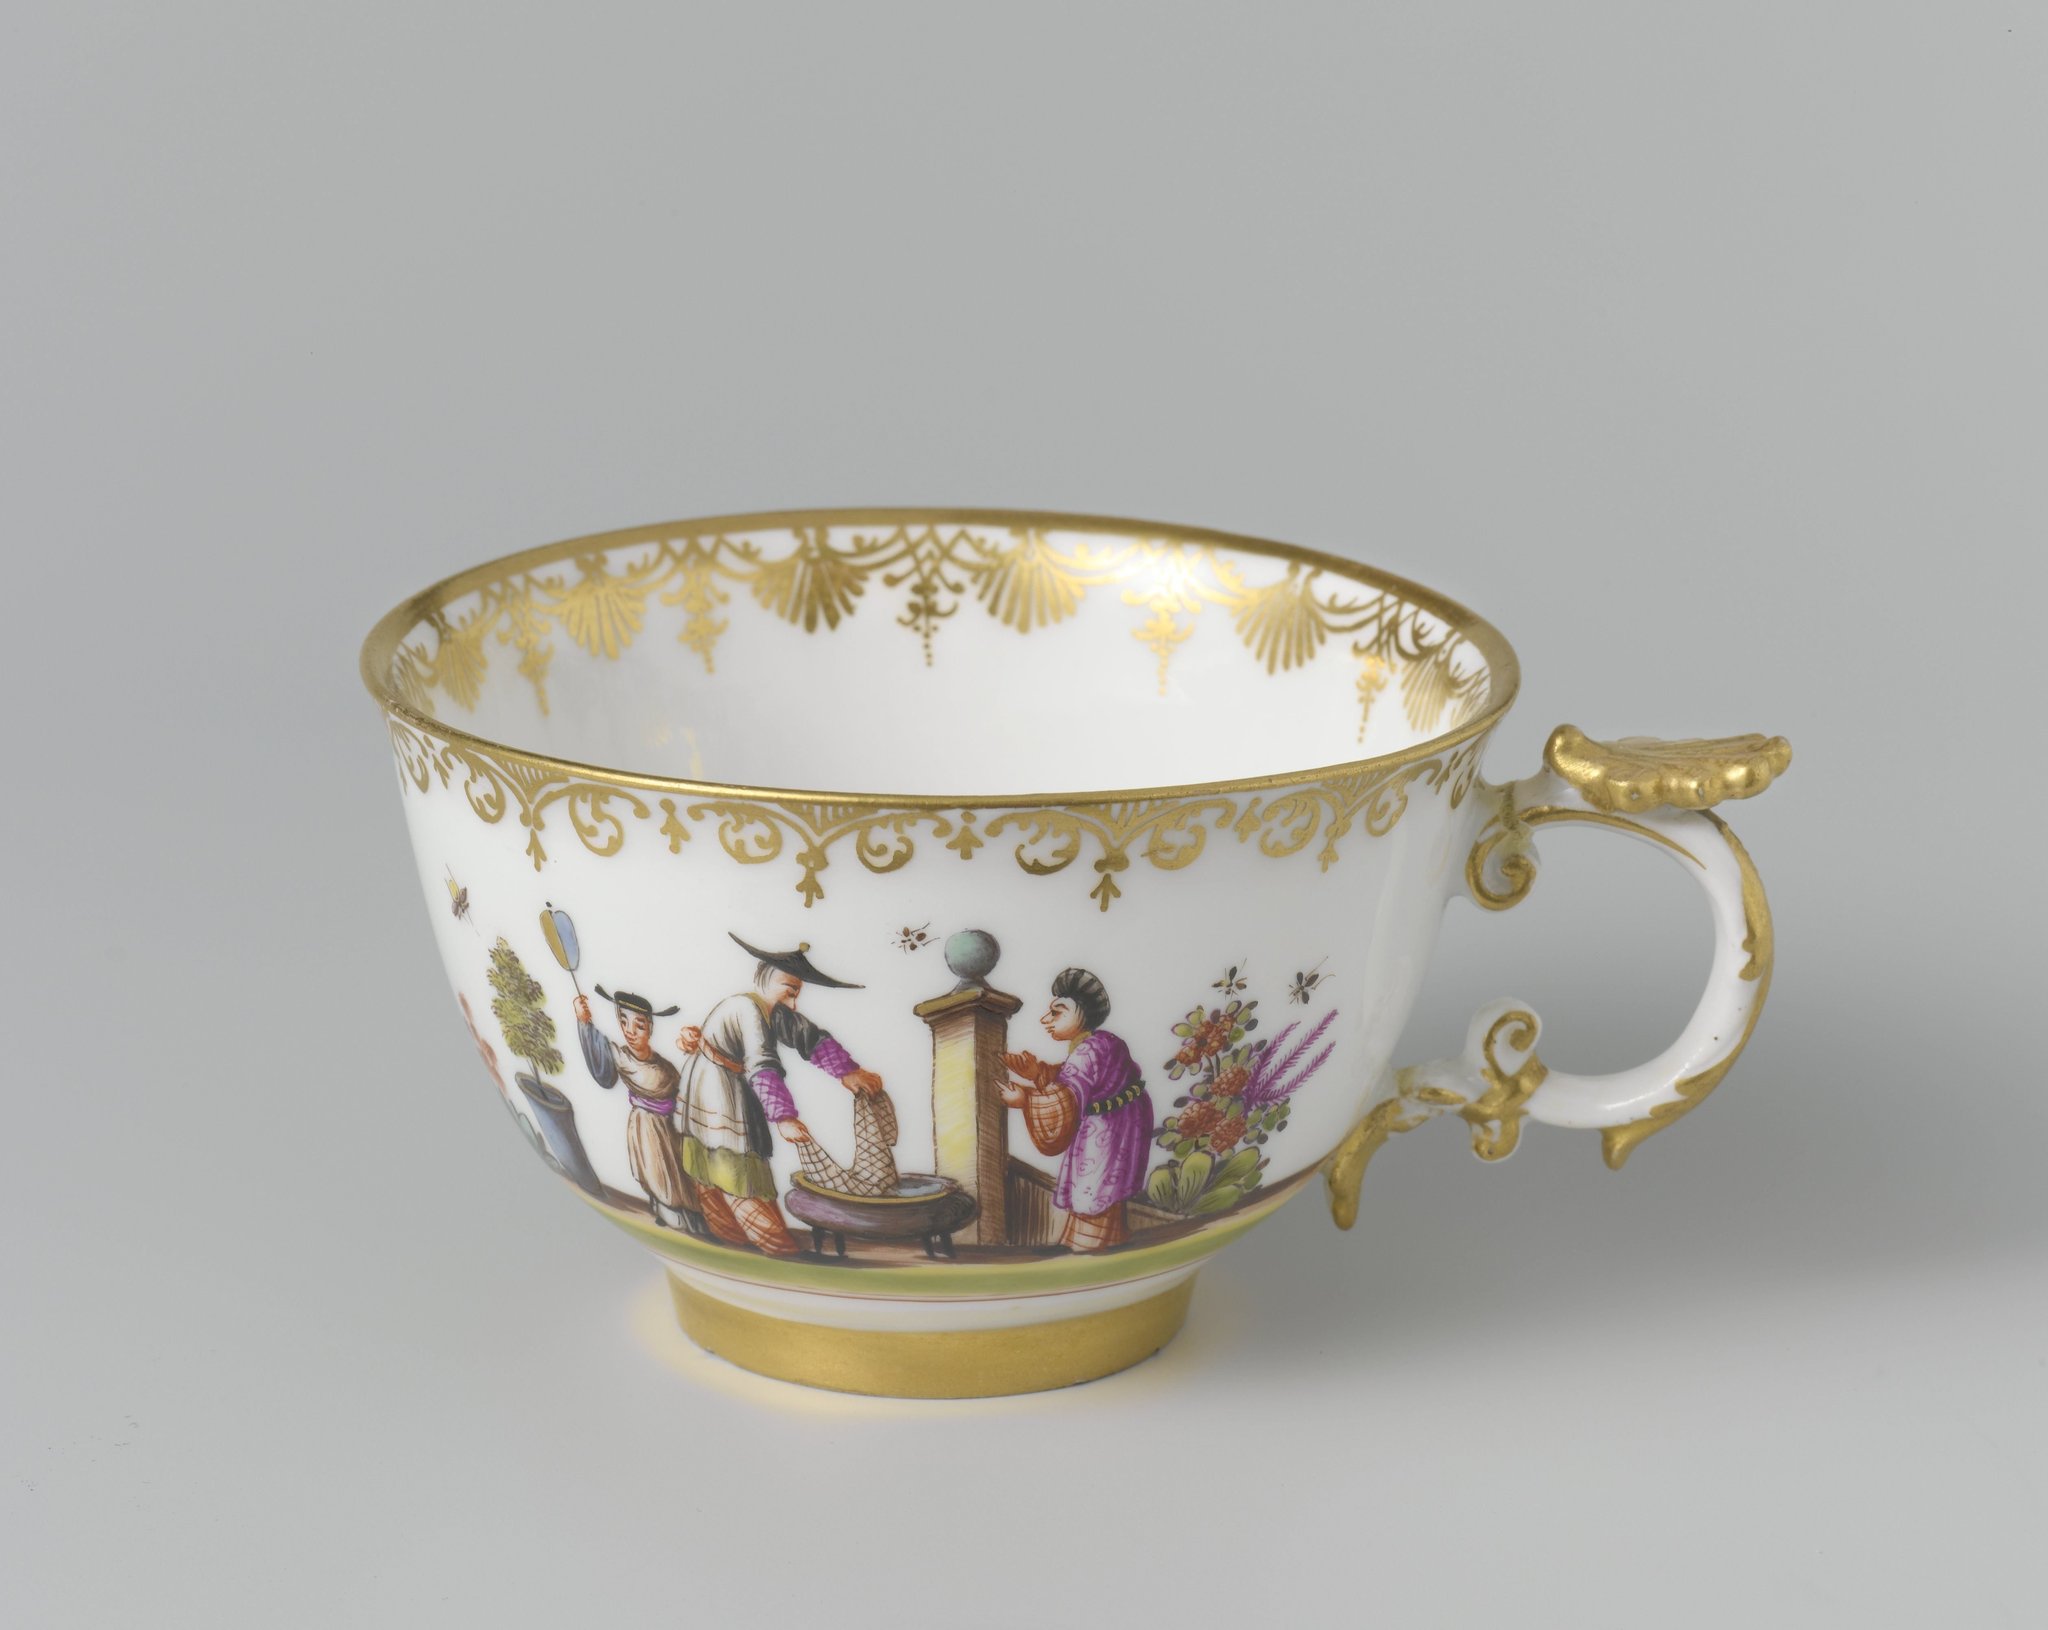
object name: trembleuse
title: Cup and saucer (<trembleuse>)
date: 1735-1740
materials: porcelain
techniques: painted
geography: meissen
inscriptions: mark, mold mark: ‘23’, number: ‘264.’, label: ‘SAMMLUNG / Dr. FRANZ OPPENHEIMER’, factory mark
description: Meissener Porzellan Manufaktur Meissen, c. 1735–1740 hard-paste porcelain